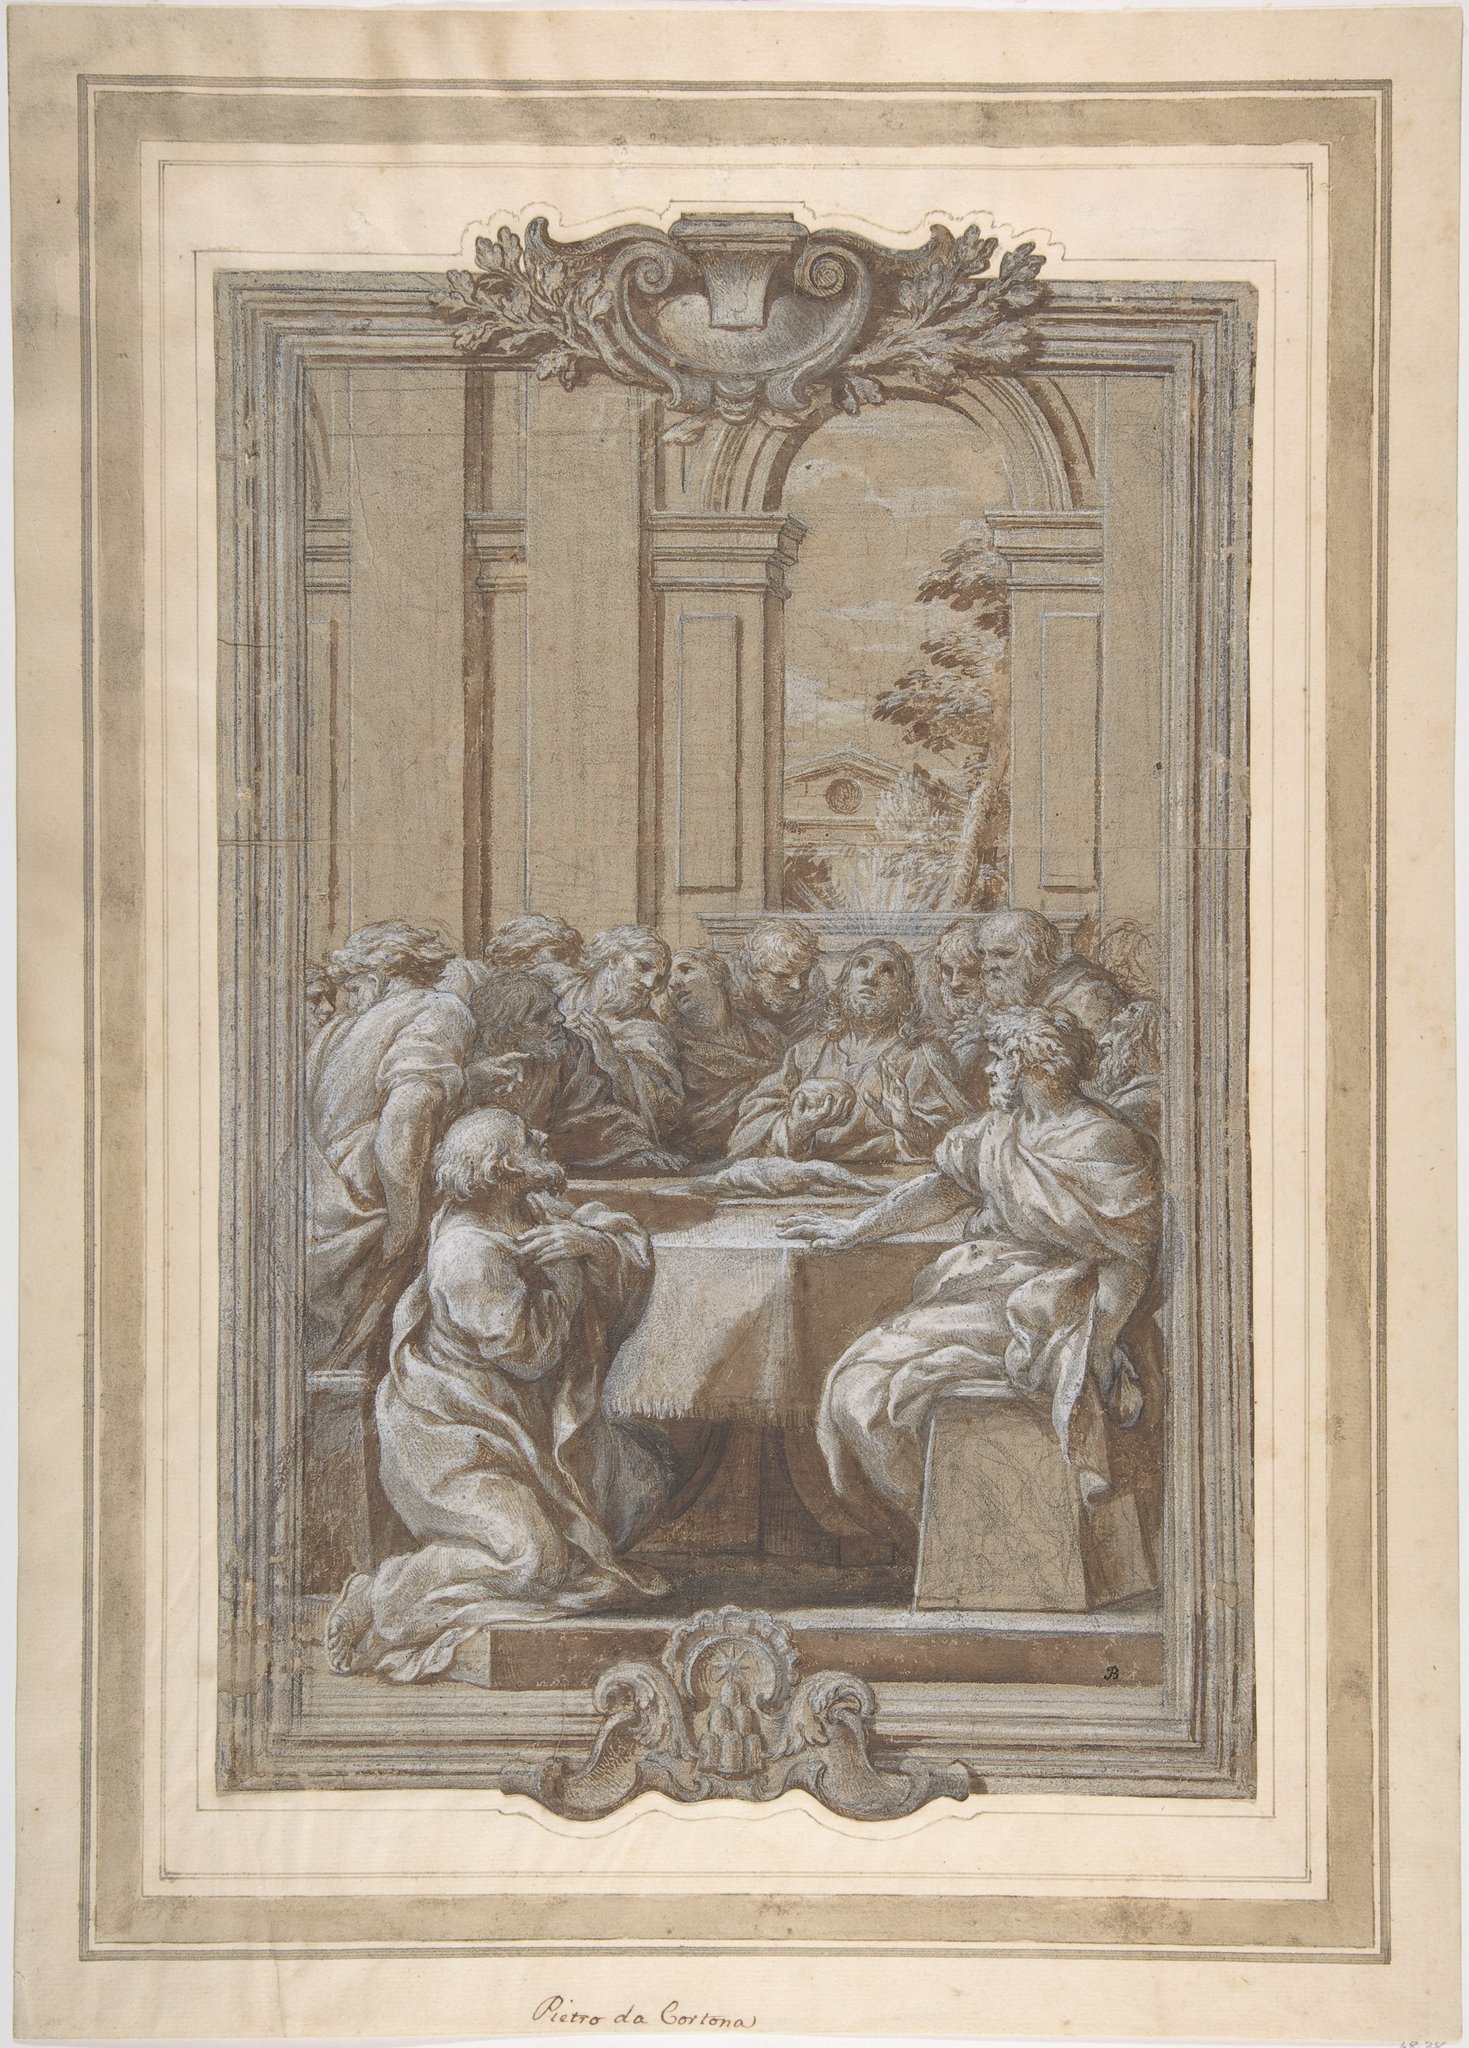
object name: drawing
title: The Last Supper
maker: ciro ferri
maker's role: artist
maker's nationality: italian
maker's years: 1634-1689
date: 1634-1689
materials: chalk, paper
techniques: brush, highlighting, wash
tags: last supper